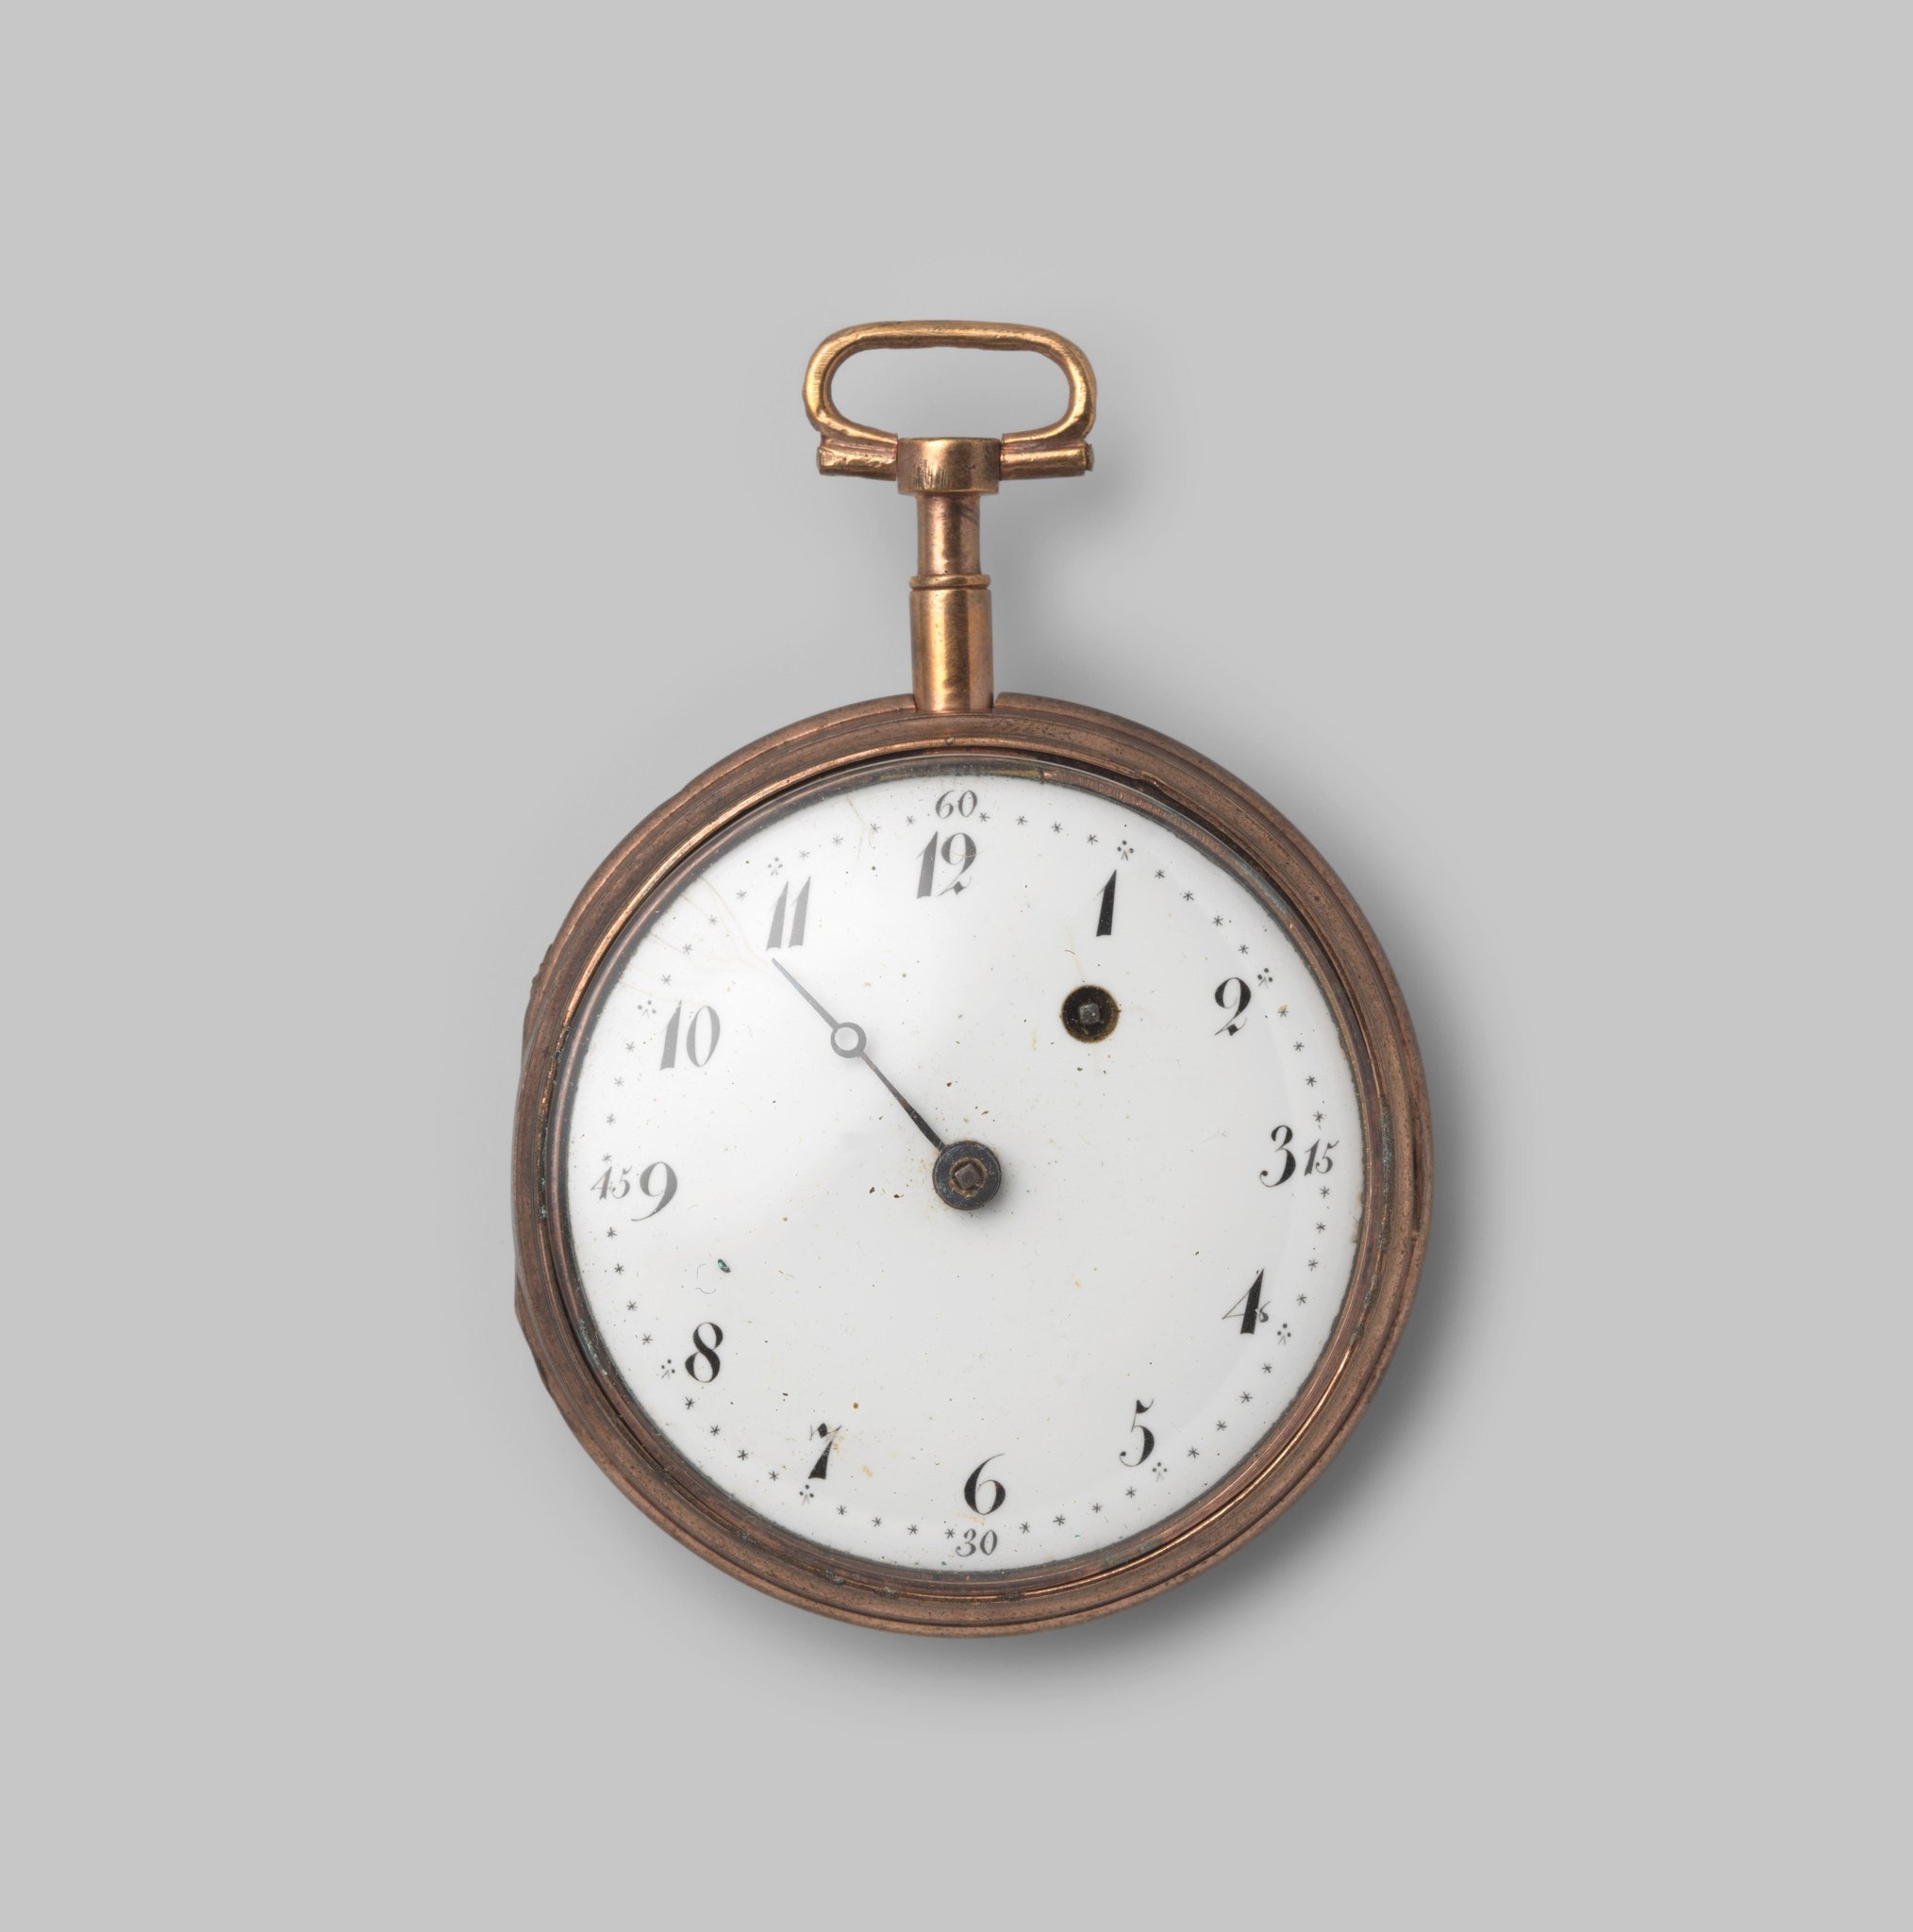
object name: jewellery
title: Horloge, verguld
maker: bonard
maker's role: clockmaker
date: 1800-1900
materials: copper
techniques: gilding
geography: lausanne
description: Verguld koperen horloge met wit geëmailleerde wijzerplaat. Op de achterbodem in een ruit een liefkozend paar met daaronder in een ovaal twee figuren.